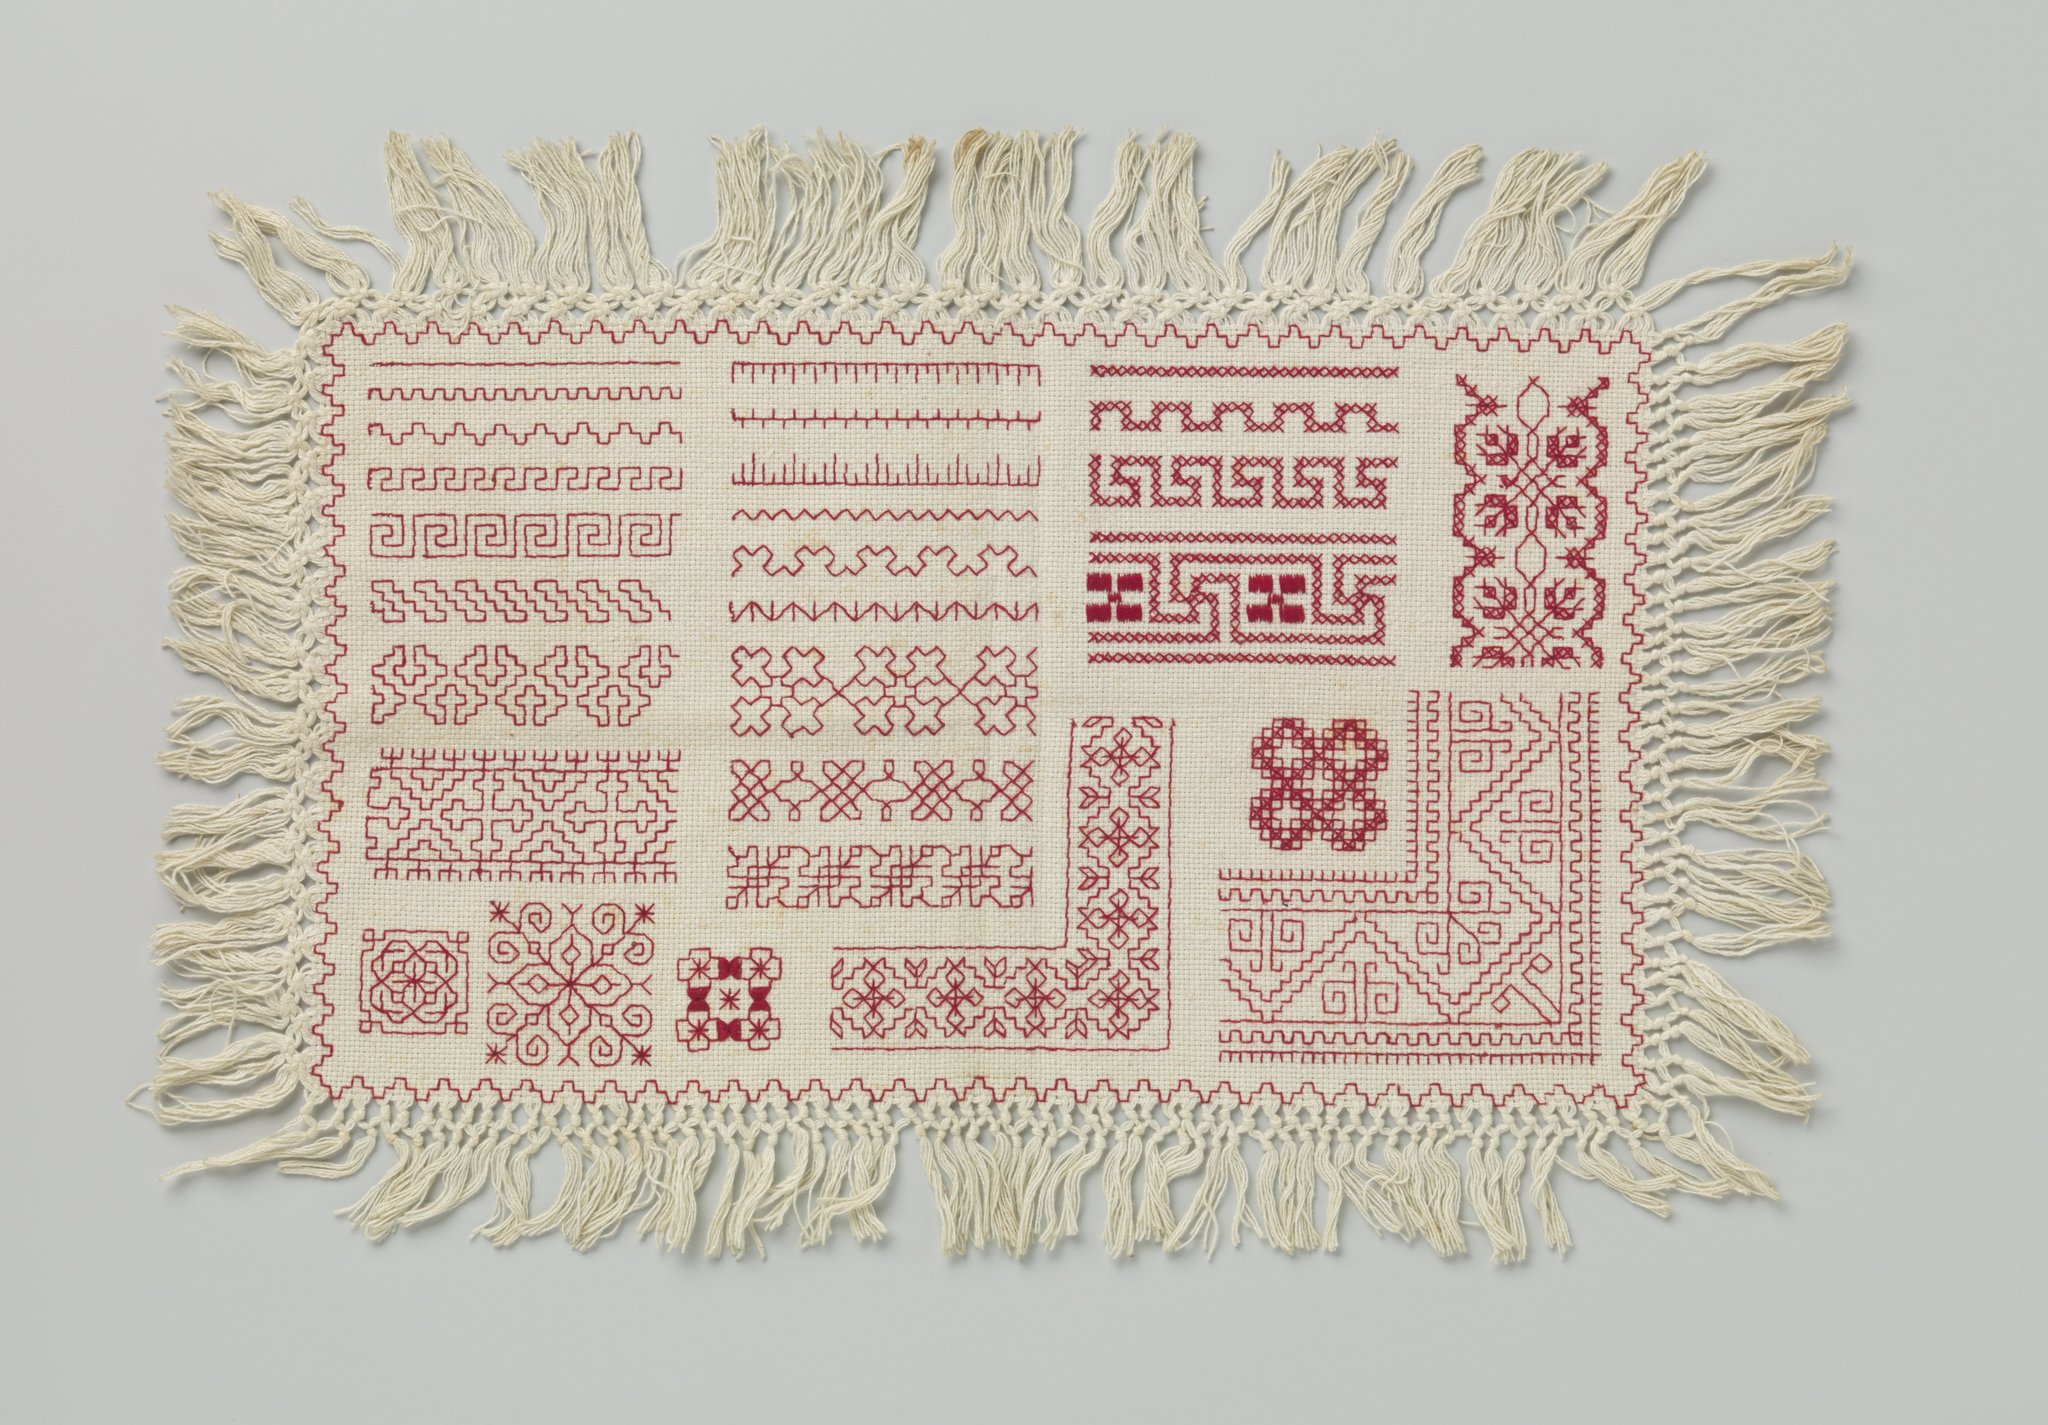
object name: borduurlap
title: Borduurlap van rode katoen op katoen.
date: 1900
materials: cotton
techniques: embroidered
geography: netherlands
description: Borduurlap van katoen op katoen. Het borduurwerk heeft vier vierkante motieven, twee hoek patronen en verschillende randpatronen. De lap is rondom afgewerkt met een geknoopte franje.